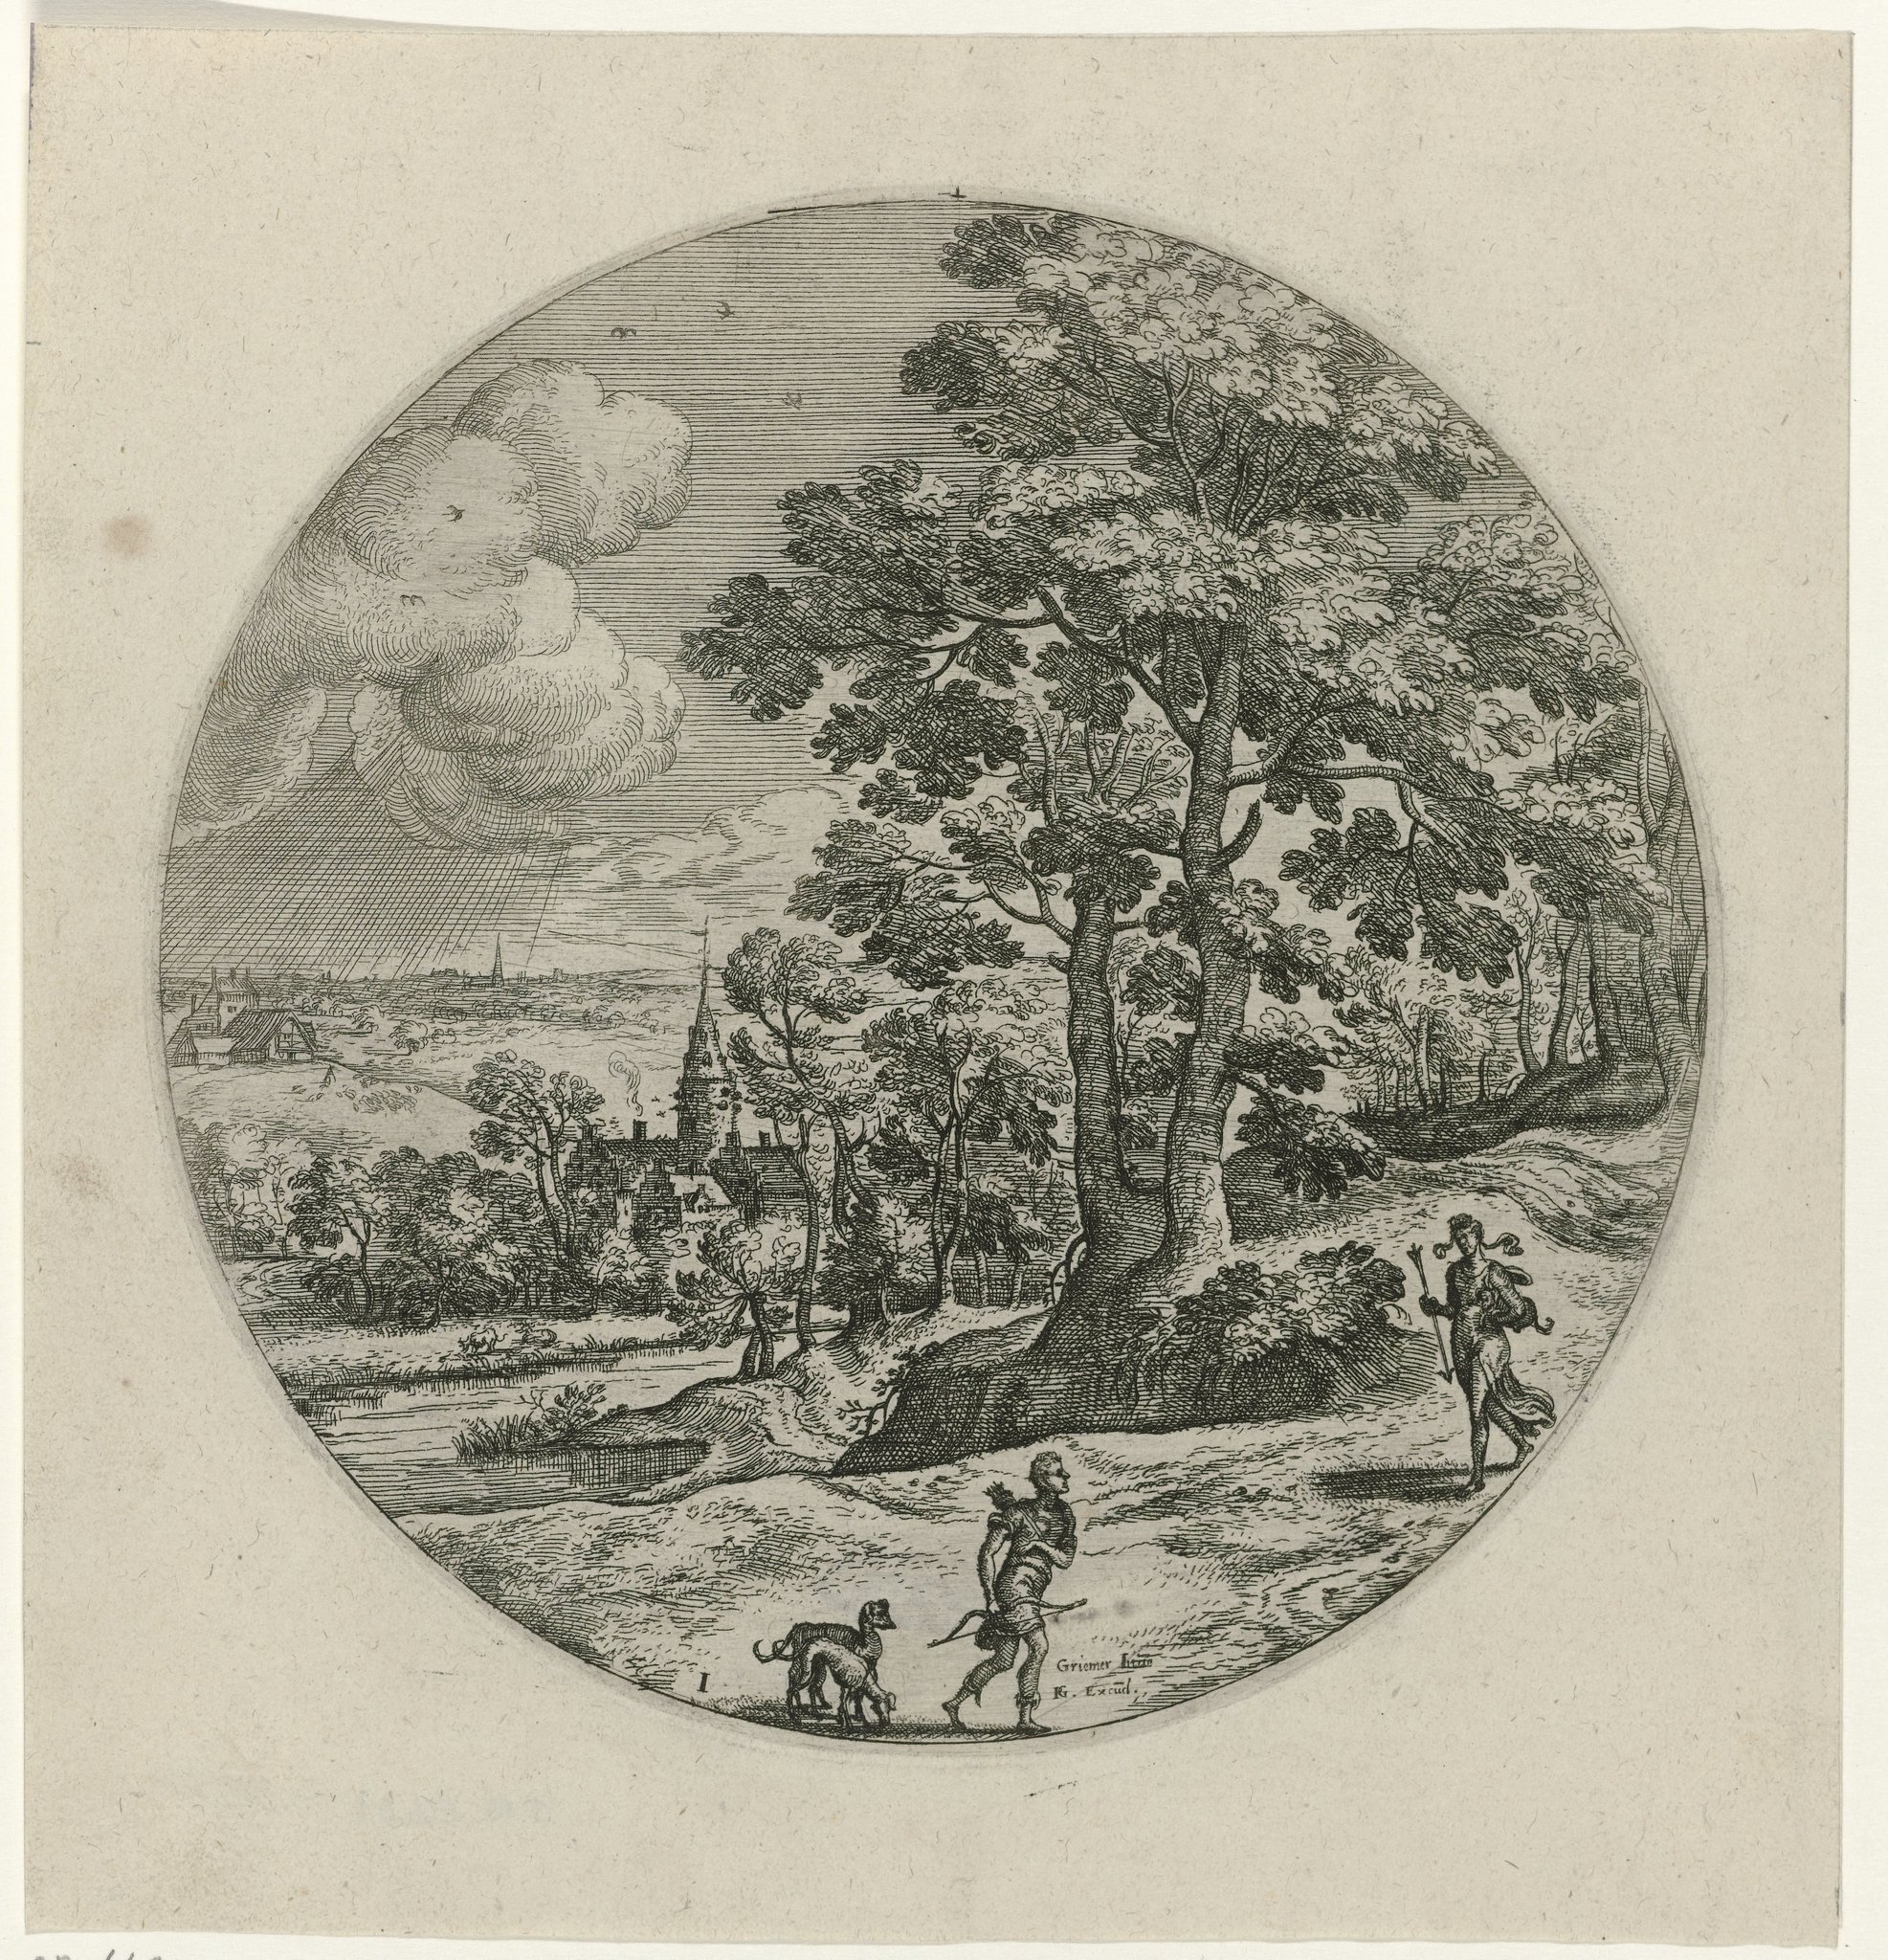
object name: print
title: Cephalus en Procris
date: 1547-1612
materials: paper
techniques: etching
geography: antwerp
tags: procris gives cephalus the dog (laelaps) and the magic spear she received from diana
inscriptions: collector's mark: Lugt 2228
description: De jager Cephalus krijgt van zijn geliefde Pricris een pijl die nooit mist. In de achtergrond een landschap. De prent is deel van een serie over het mythologische verhaal van Cephalus en Procris.